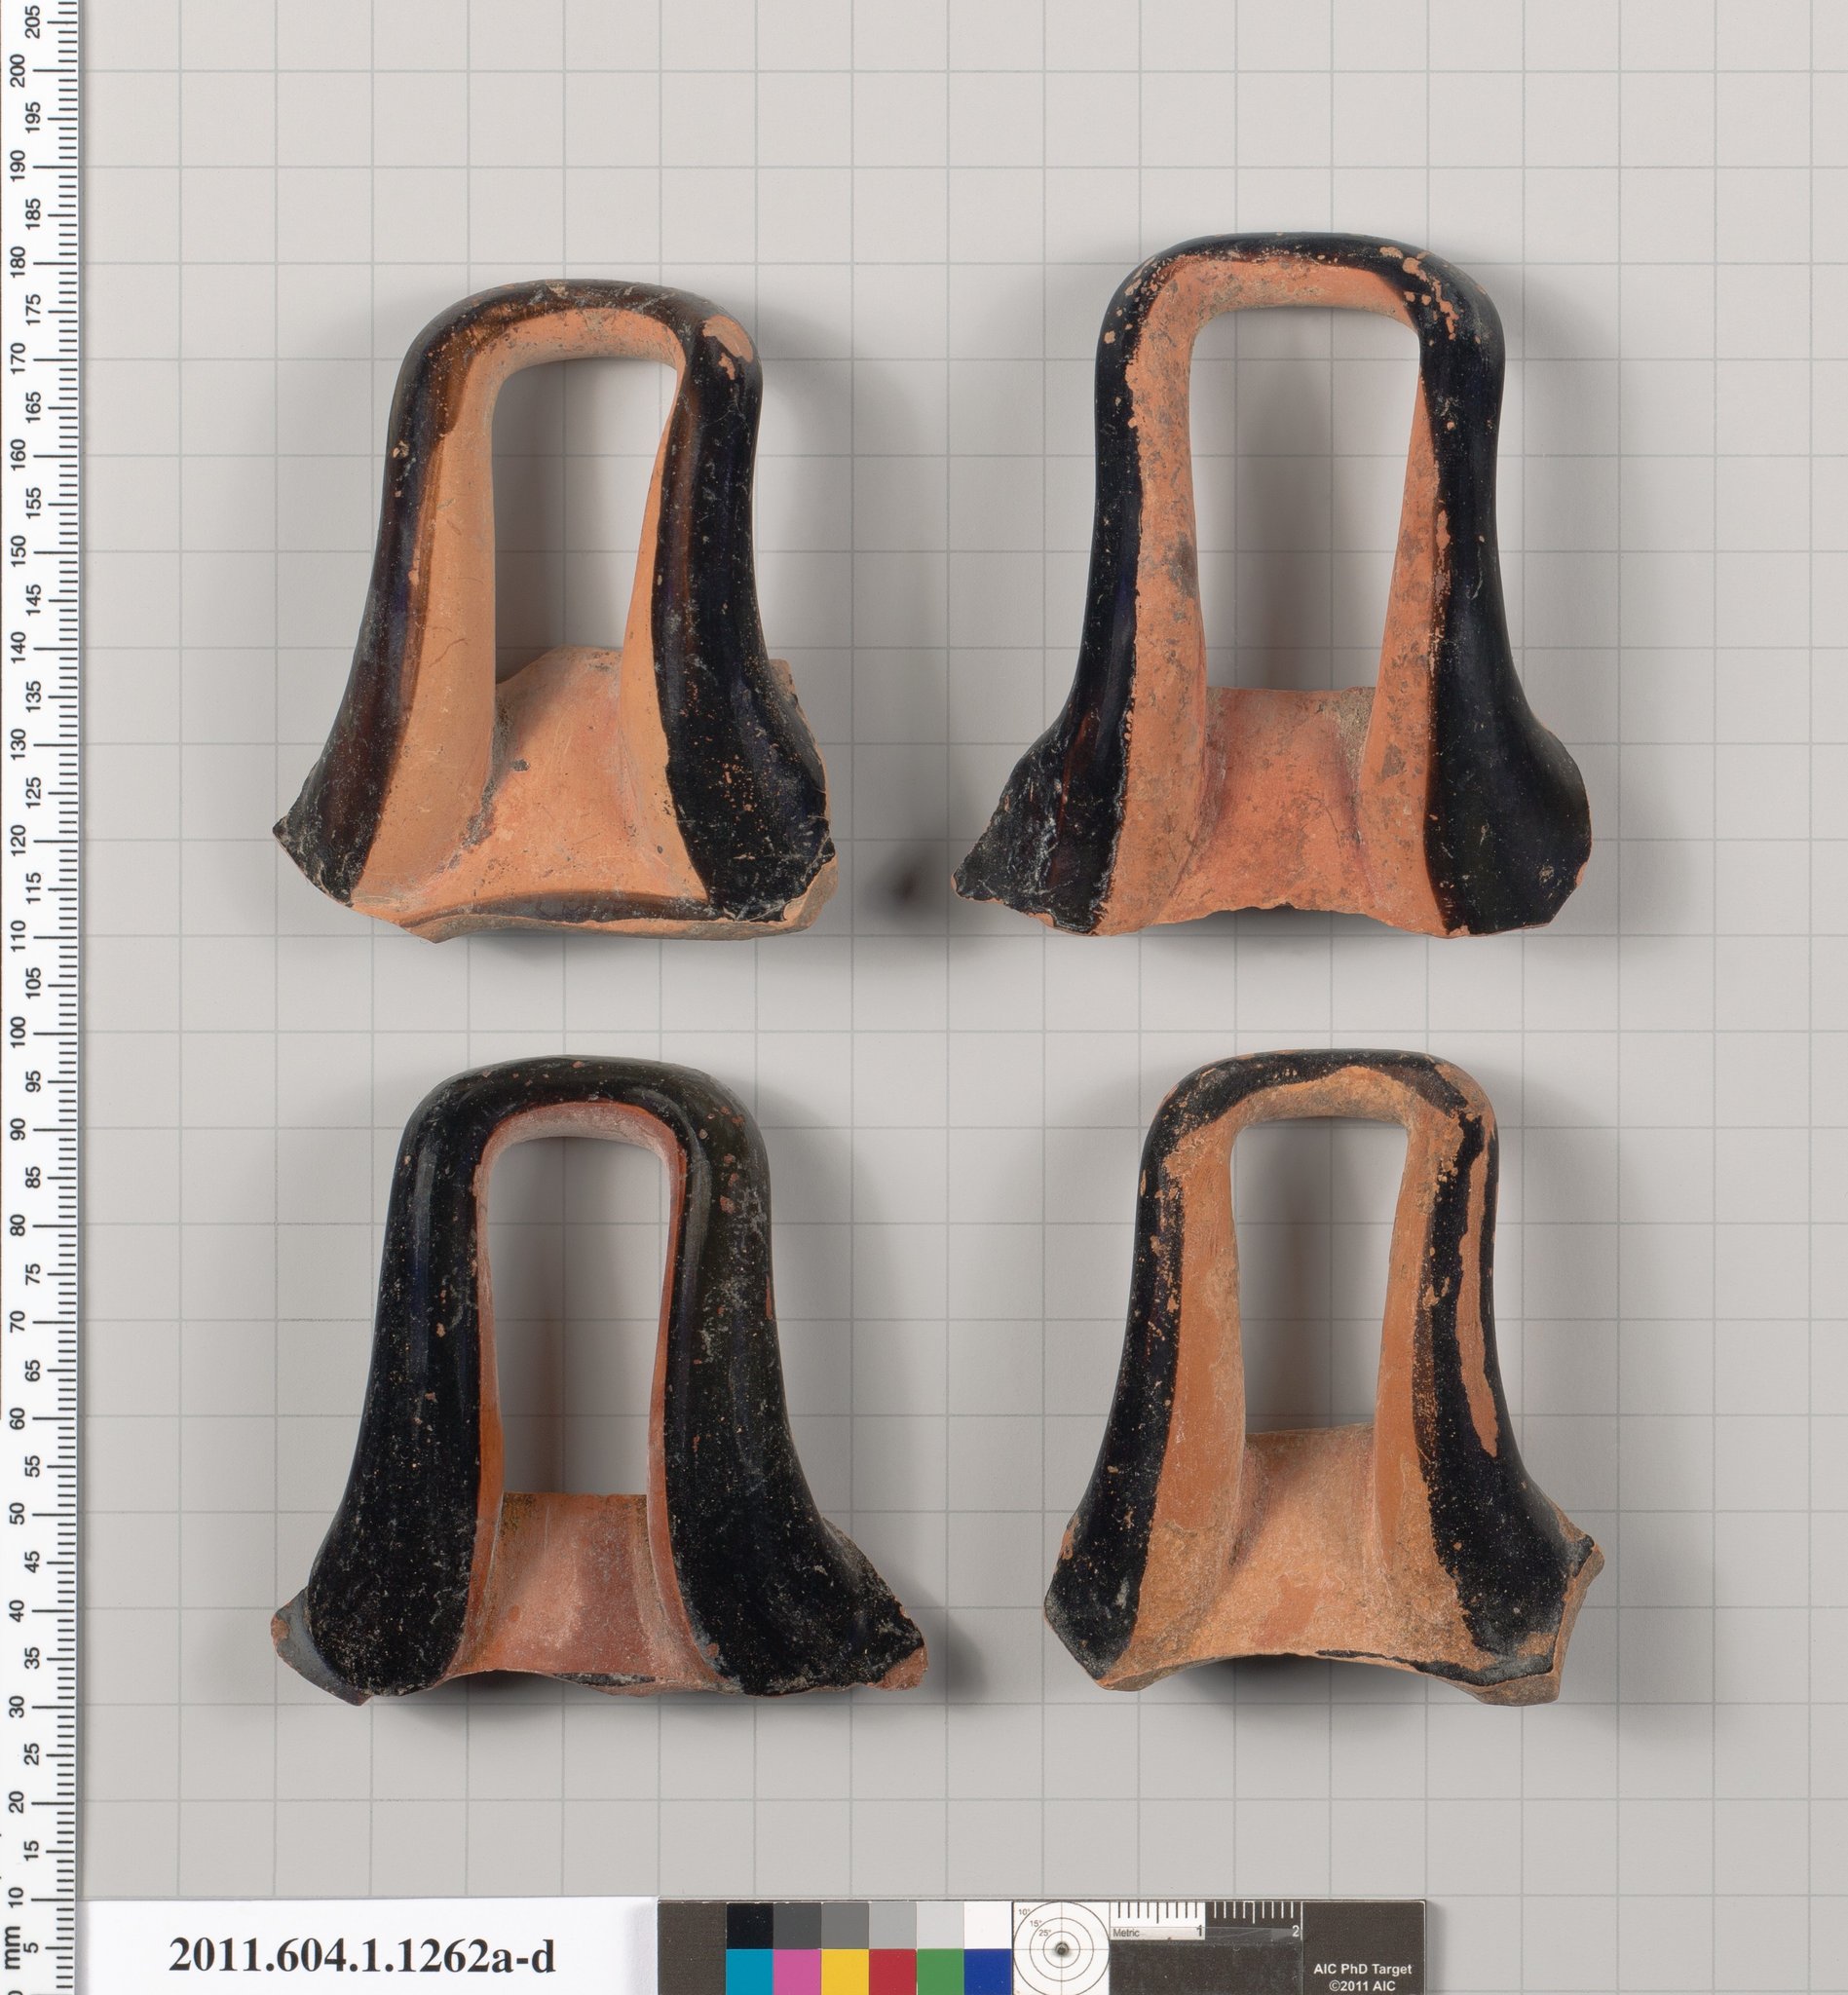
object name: kylix fragment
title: Terracotta fragments of kylikes (drinking cups)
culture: greek, attic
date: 500-401 BCE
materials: terracotta